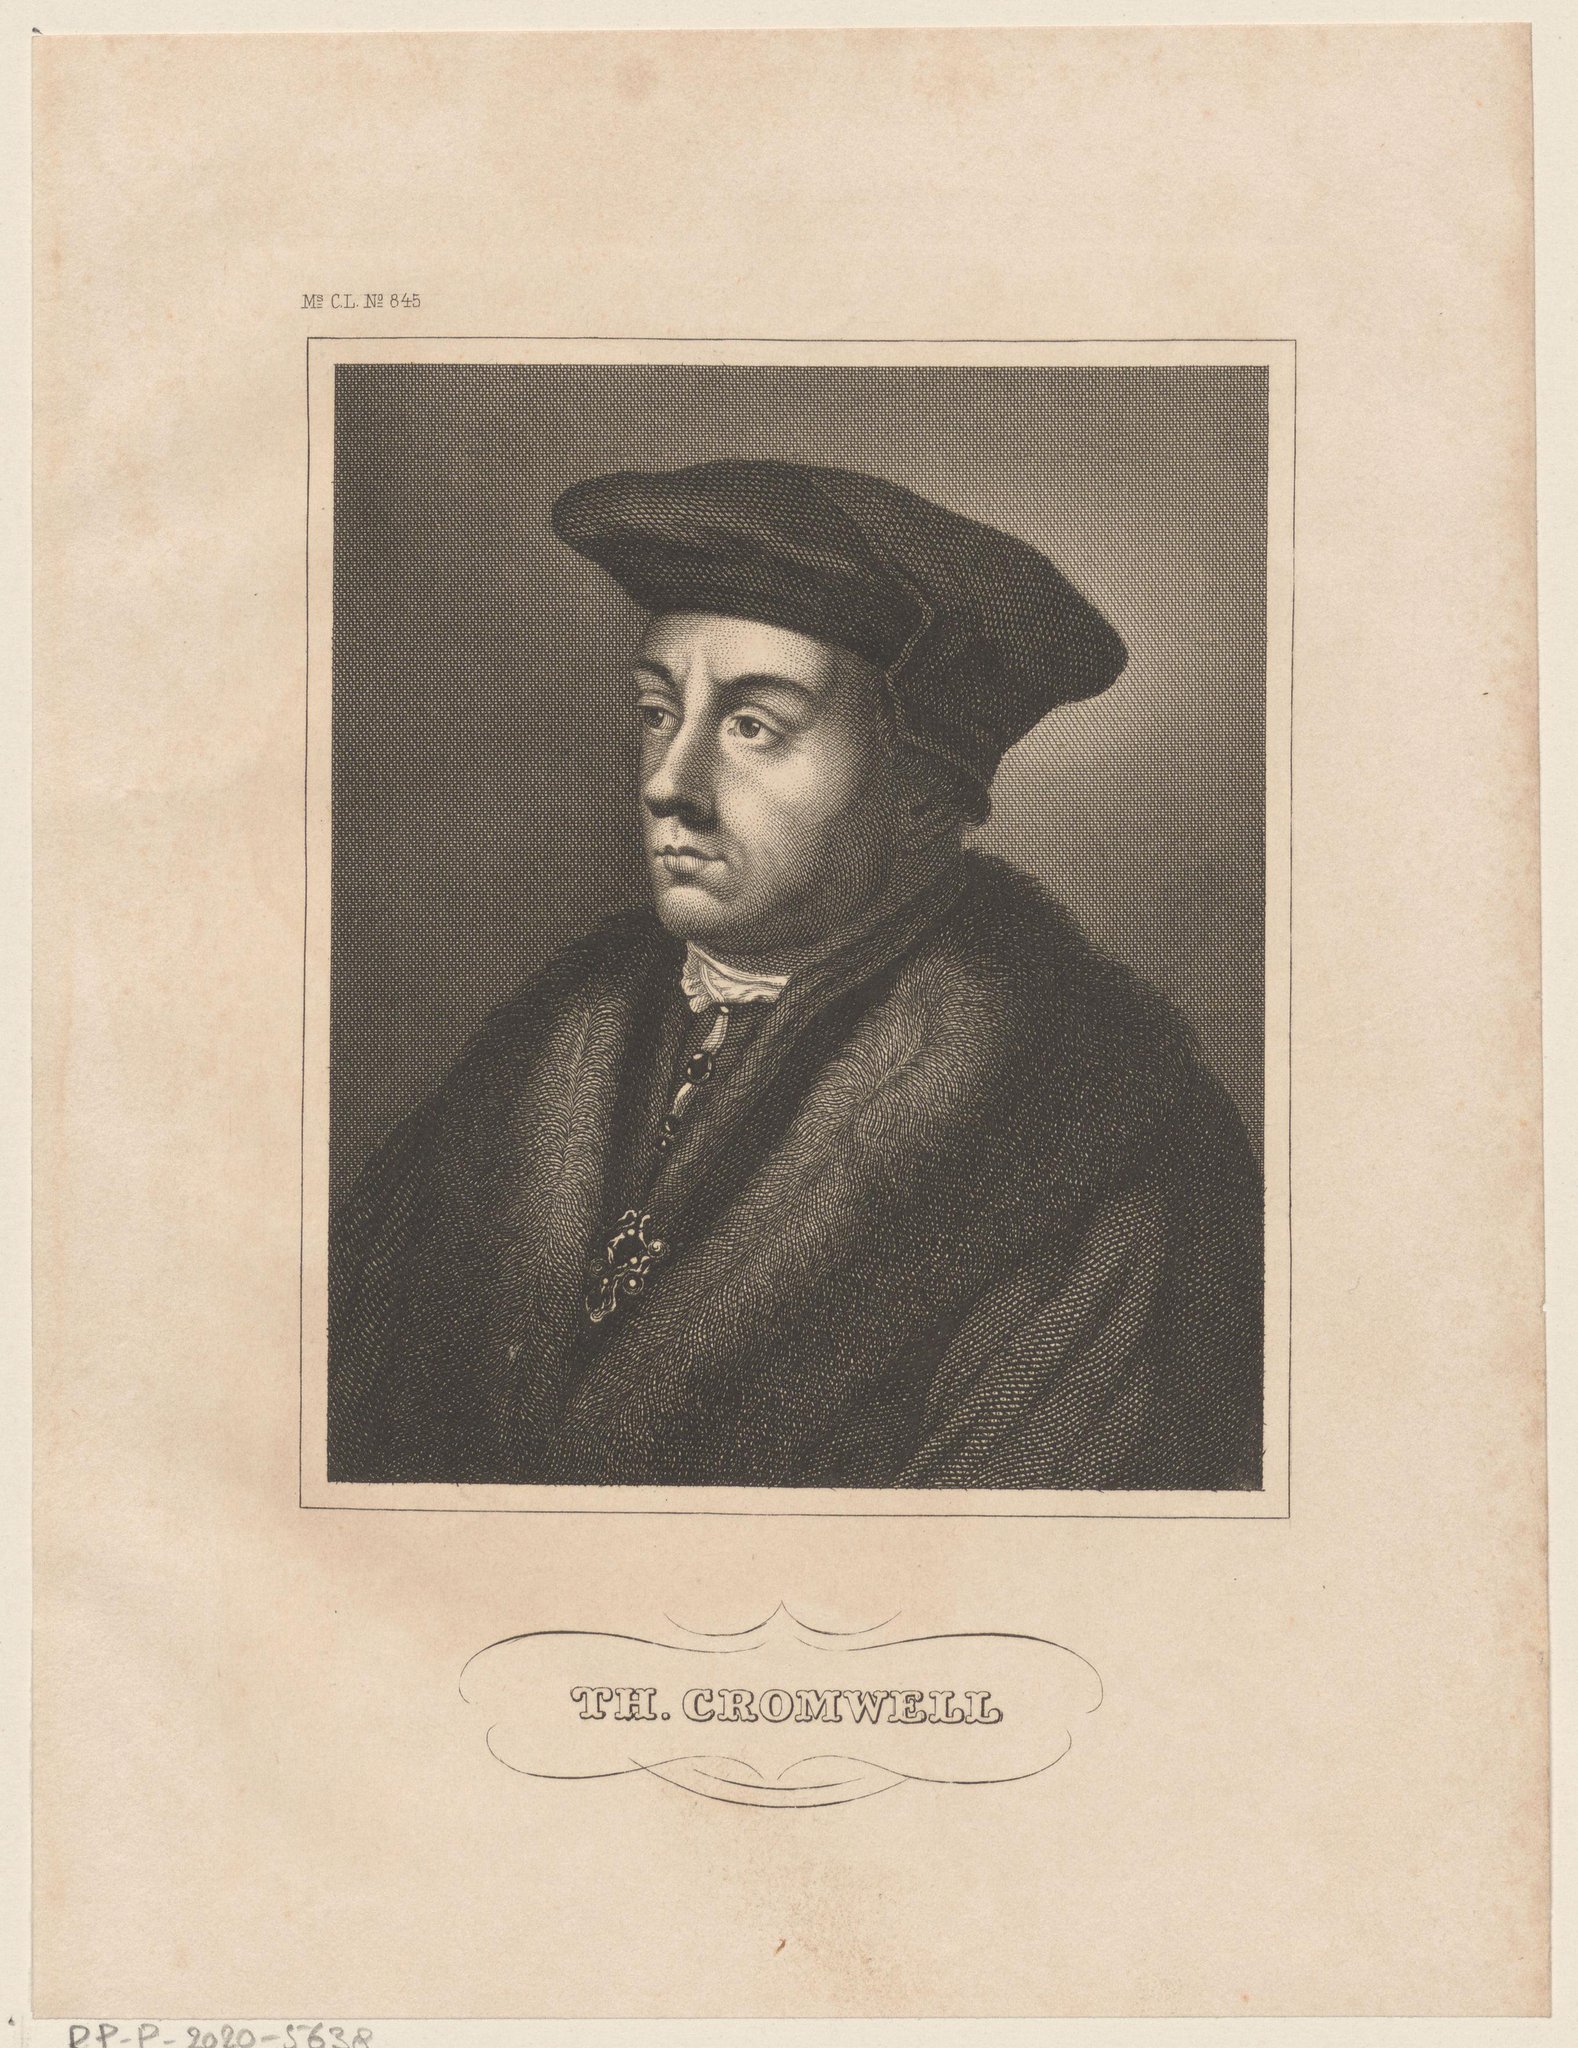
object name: print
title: Portret van Thomas Cromwell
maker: Anonymous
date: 1839-1855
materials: paper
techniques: engraving, etching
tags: historical persons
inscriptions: : Lugt 2228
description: Prent mogelijk uit: Meyer, Joseph. Conversations-Lexikon für die gebildeten Stände. Hildburghausen: Bibliographisches Institut, 1839-1855.